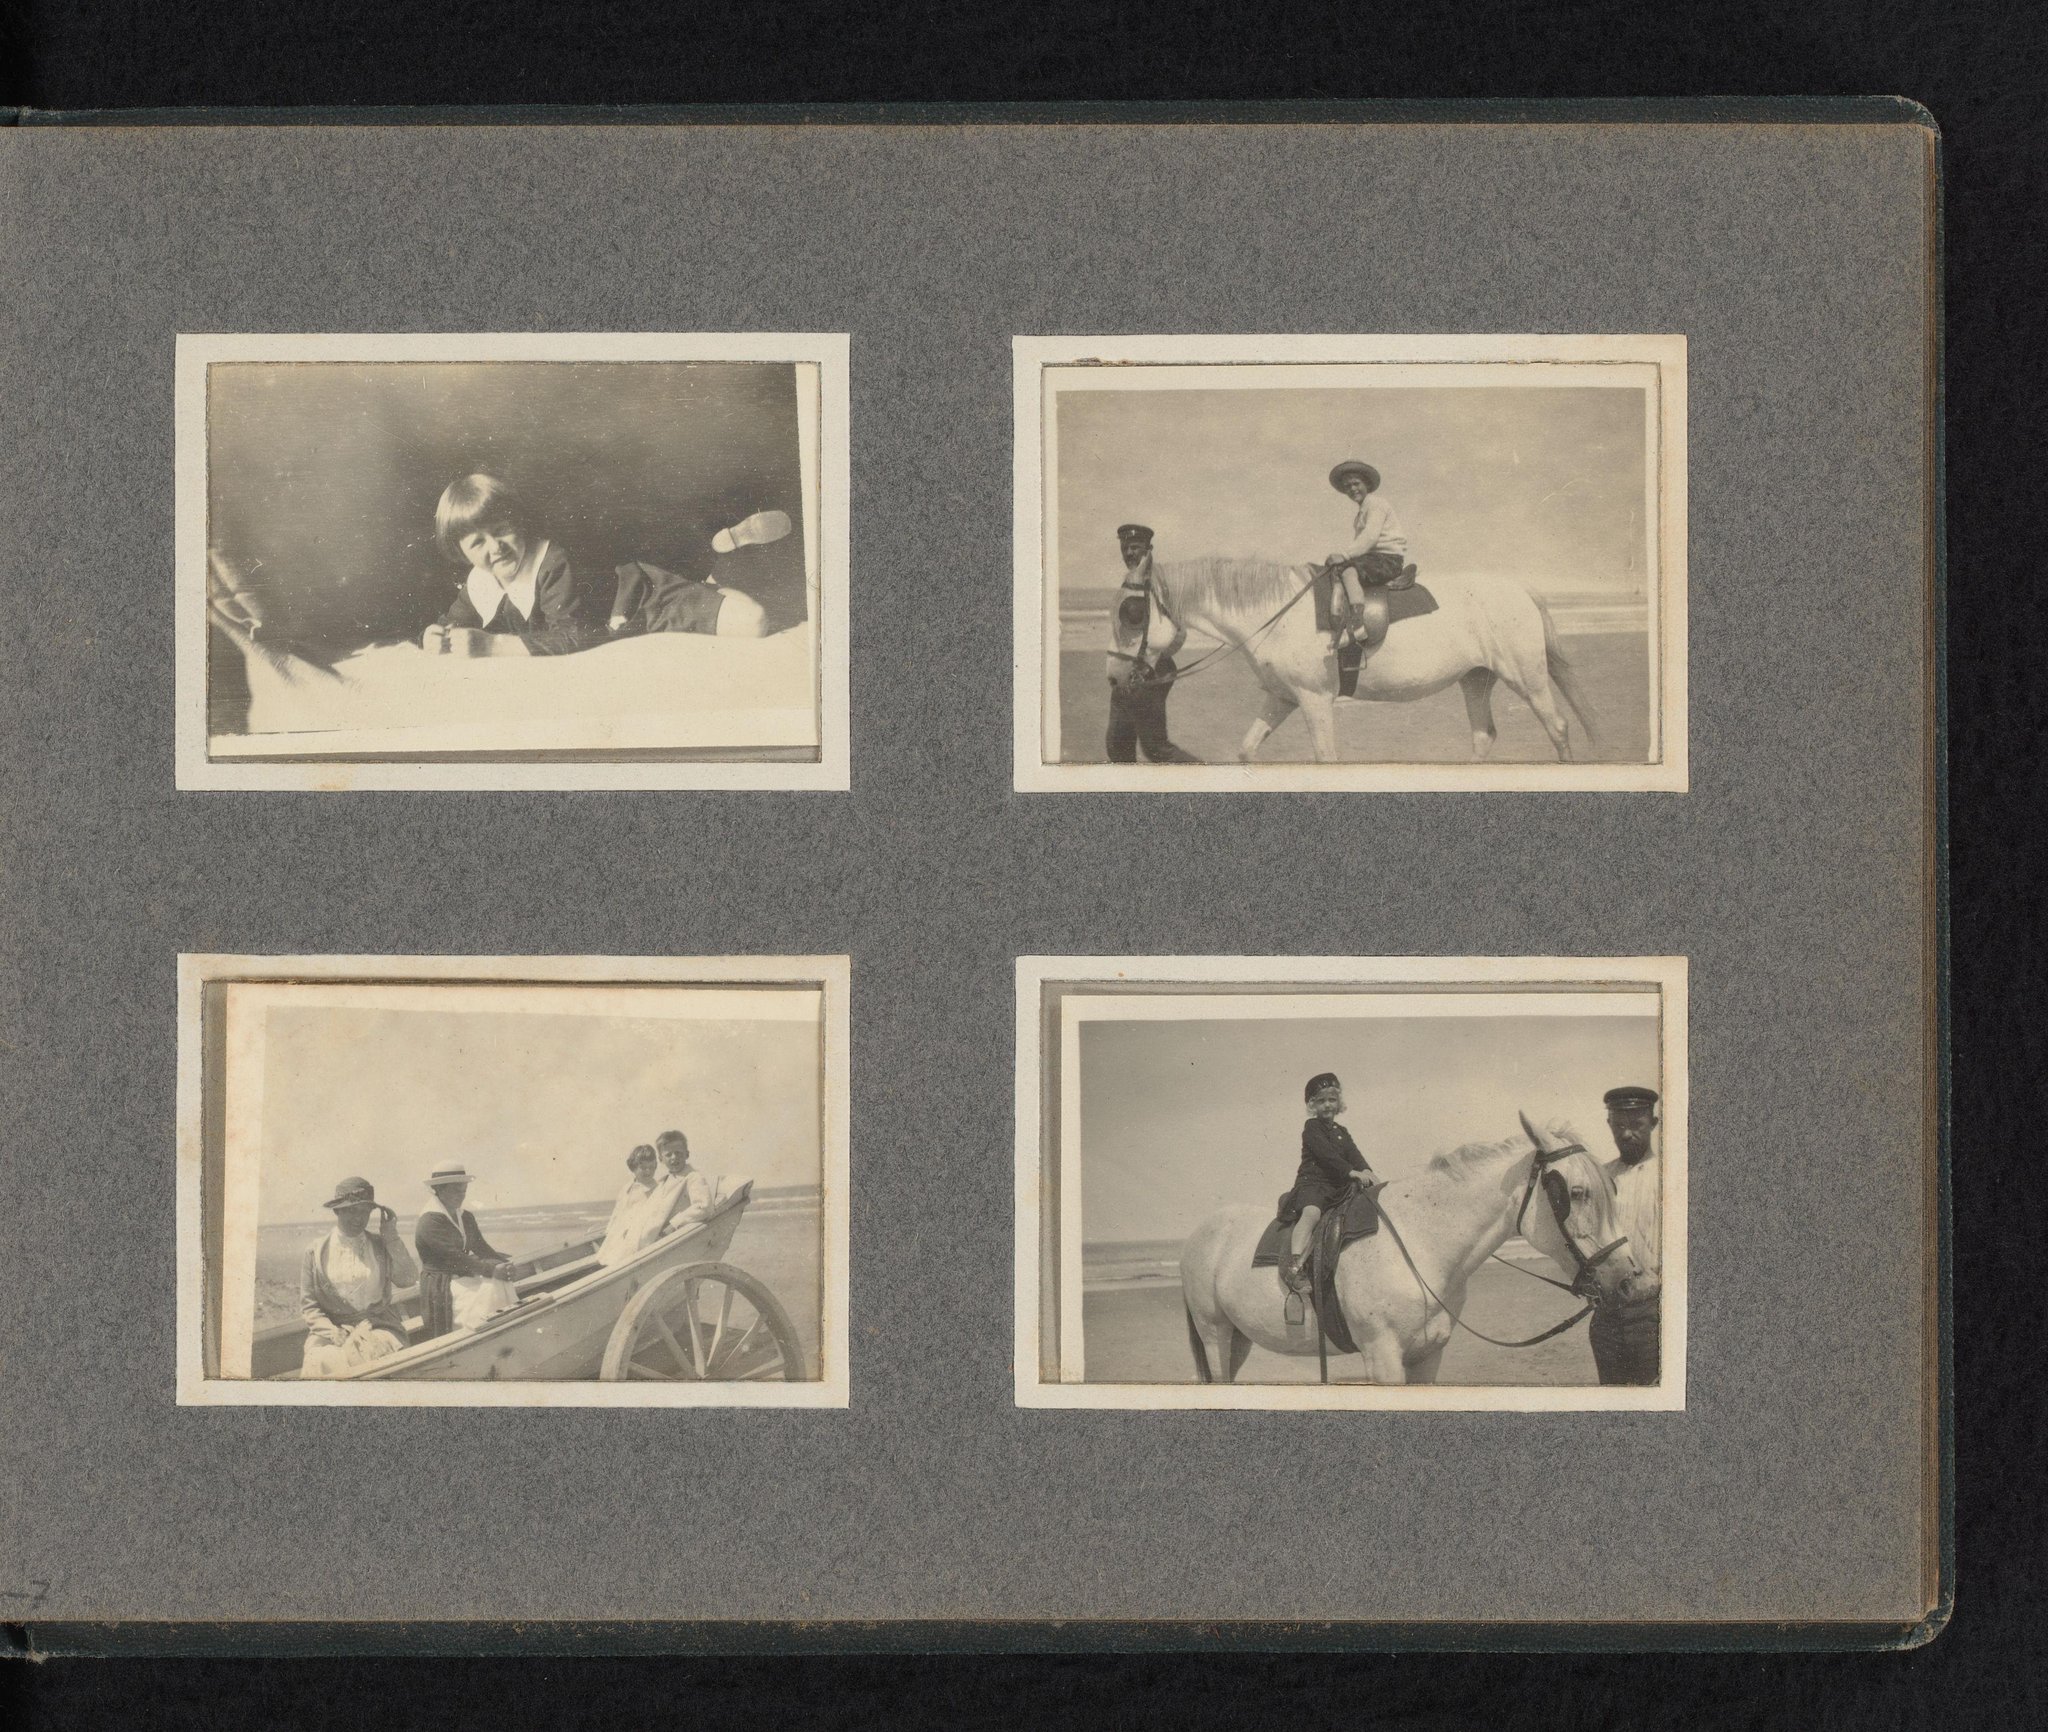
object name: album leaf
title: Familie van den Berg op een strand, mogelijk in Noordwijk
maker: hendrik herman van den berg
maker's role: amateurfotograaf, jurist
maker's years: 1875-1944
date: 1918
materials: paper, cardboard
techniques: gelatin silver print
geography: noordwijk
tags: beach (as place of recreation)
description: Deze foto's zijn onderdeel van een album.